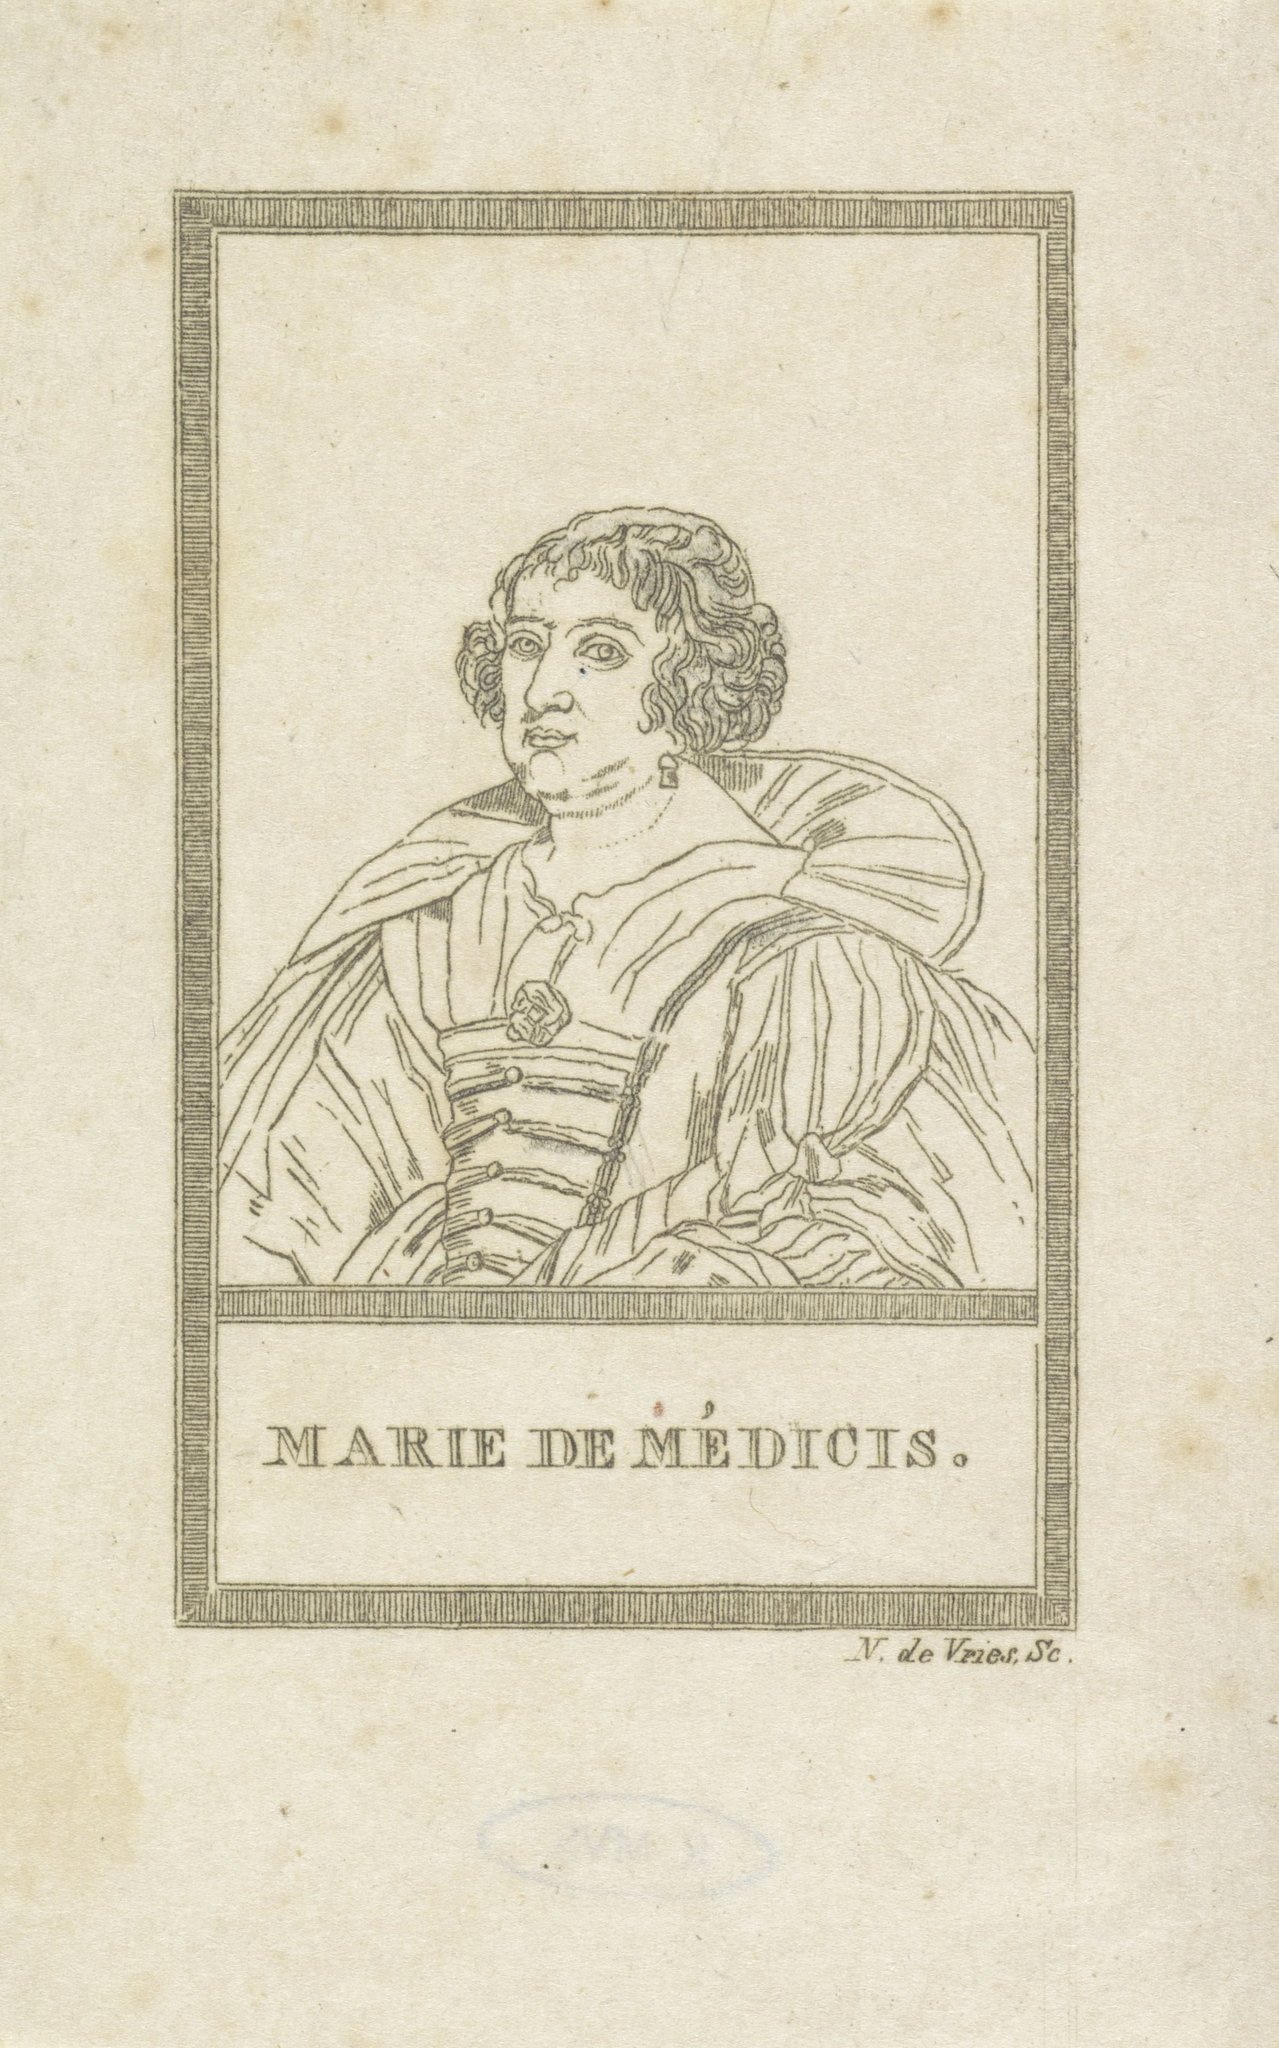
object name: print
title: Portret van Maria de' Medici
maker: n. de vries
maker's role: print maker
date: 1800-1900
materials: paper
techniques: etching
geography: netherlands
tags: cologne, maria de' medici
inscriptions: collector's mark: Lugt 2228